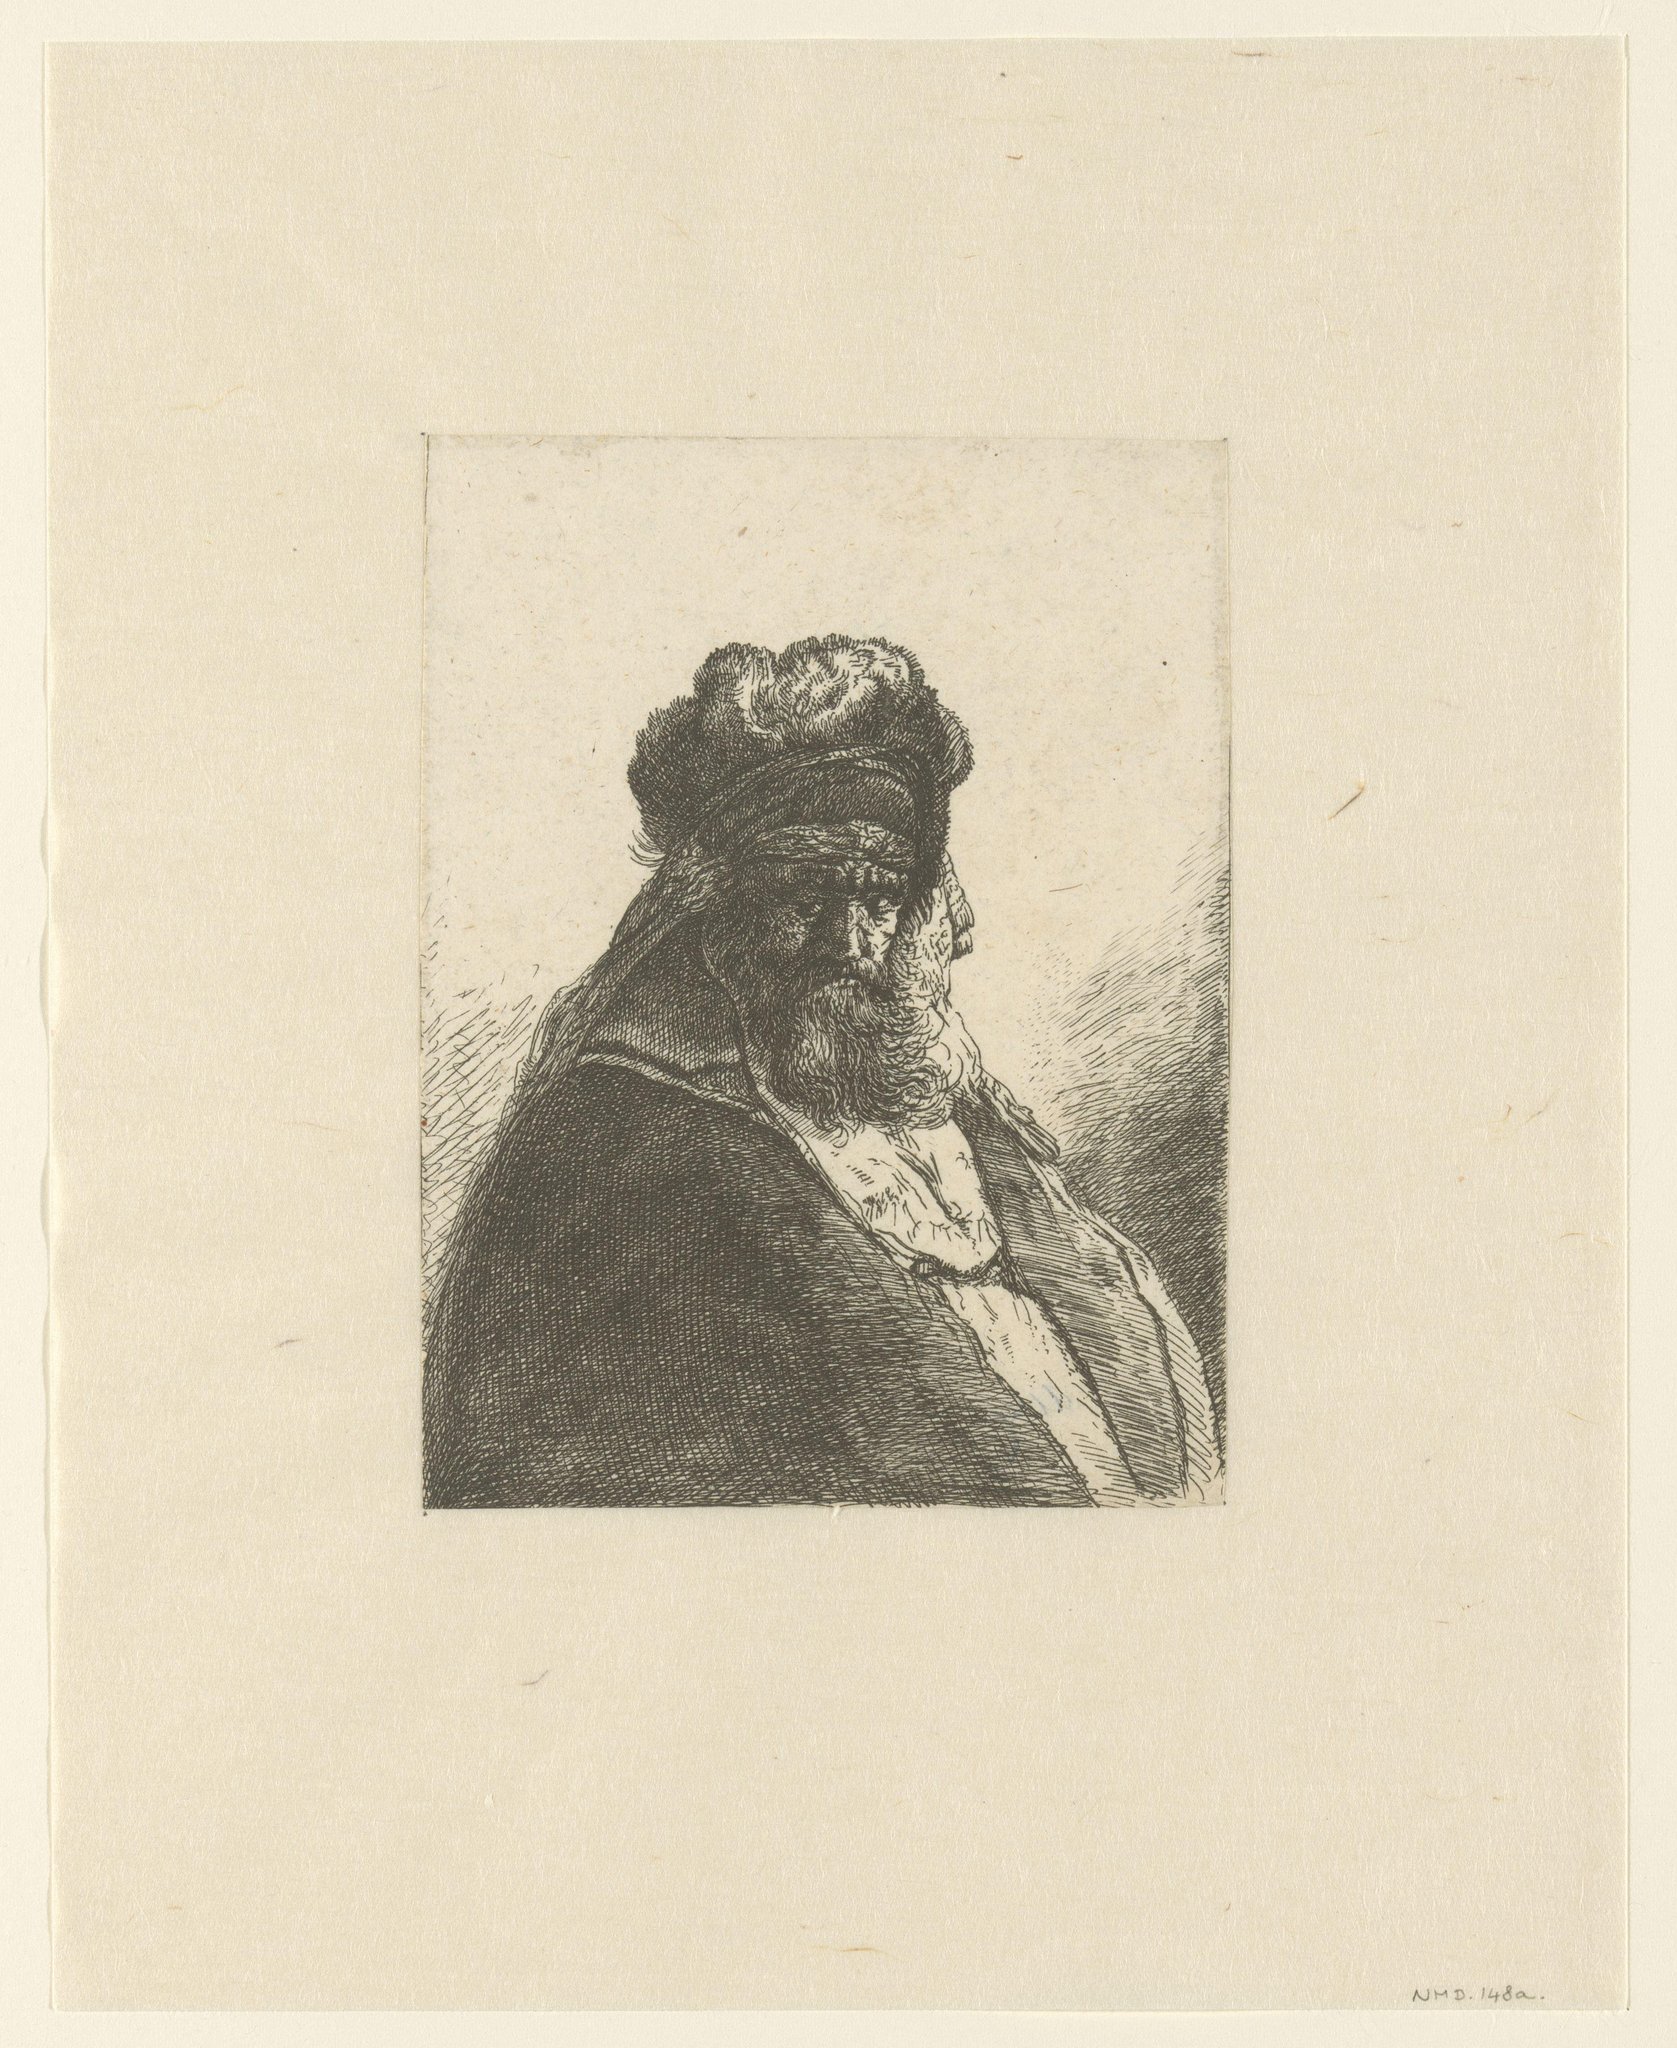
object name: print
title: Bearded old man in a high fur cap, with eyes closed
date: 1761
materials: paper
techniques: etching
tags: head-gear (with name), old man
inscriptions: collector's mark: Lugt 2228, collector's mark: ‘handtekening’, collector's mark: Lugt 2760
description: Spiegelbeeldige kopie naar de gelijknamige prent van Rembrandt.